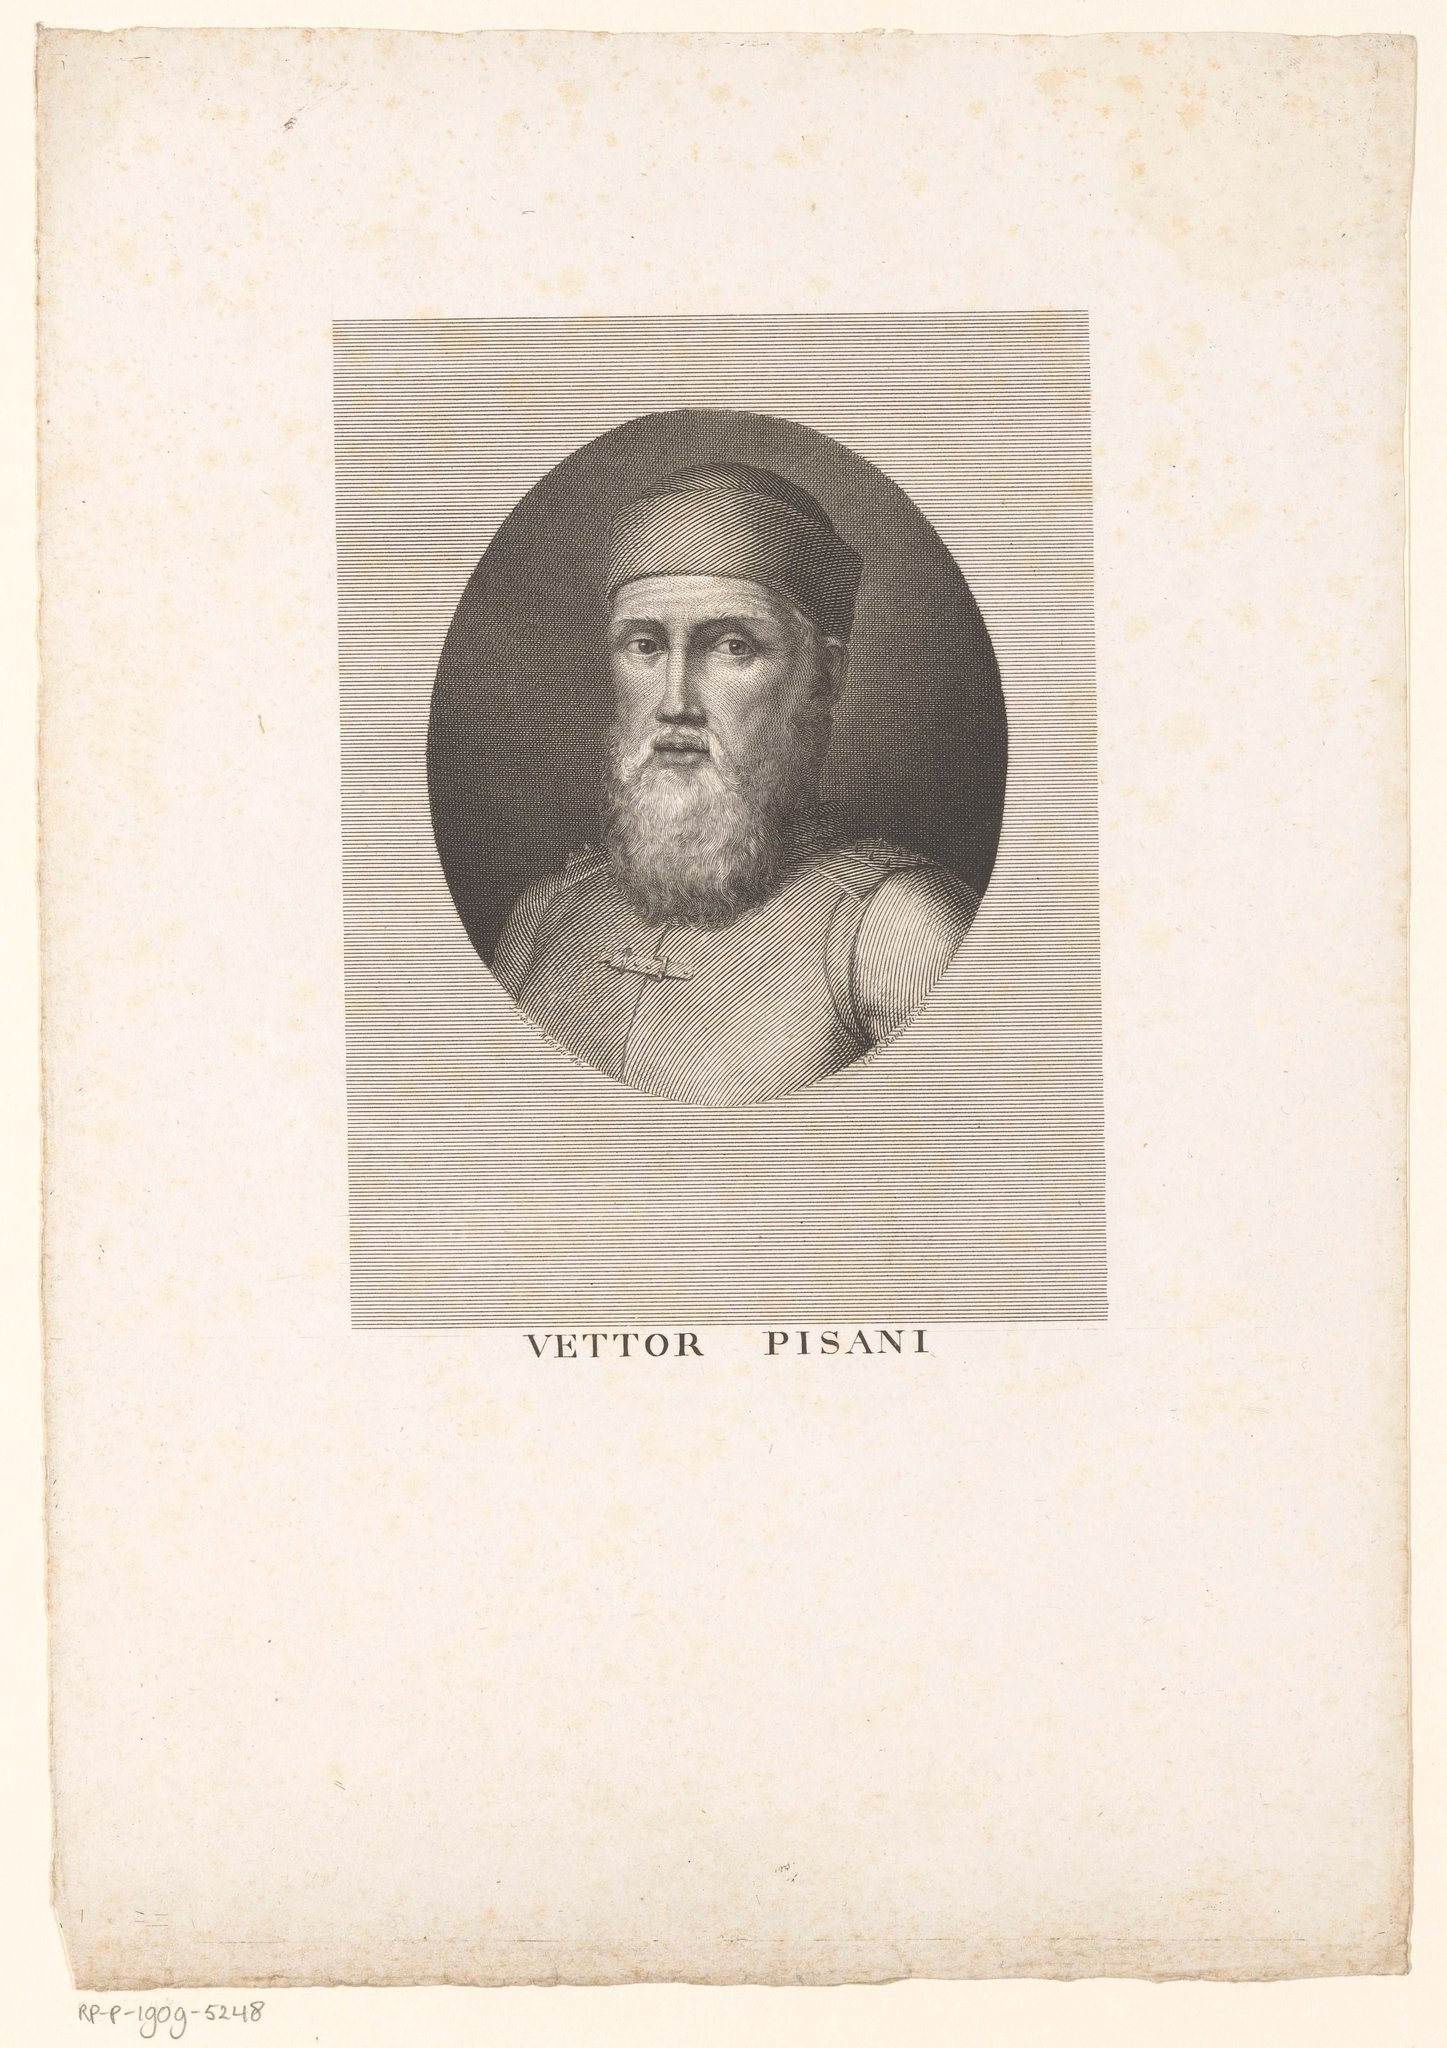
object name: print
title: Portret van admiraal Vetter Pisani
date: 1785-1885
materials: paper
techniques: engraving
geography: italy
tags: historical persons, commander-in-chief, admiral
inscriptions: collector's mark: Lugt 2228